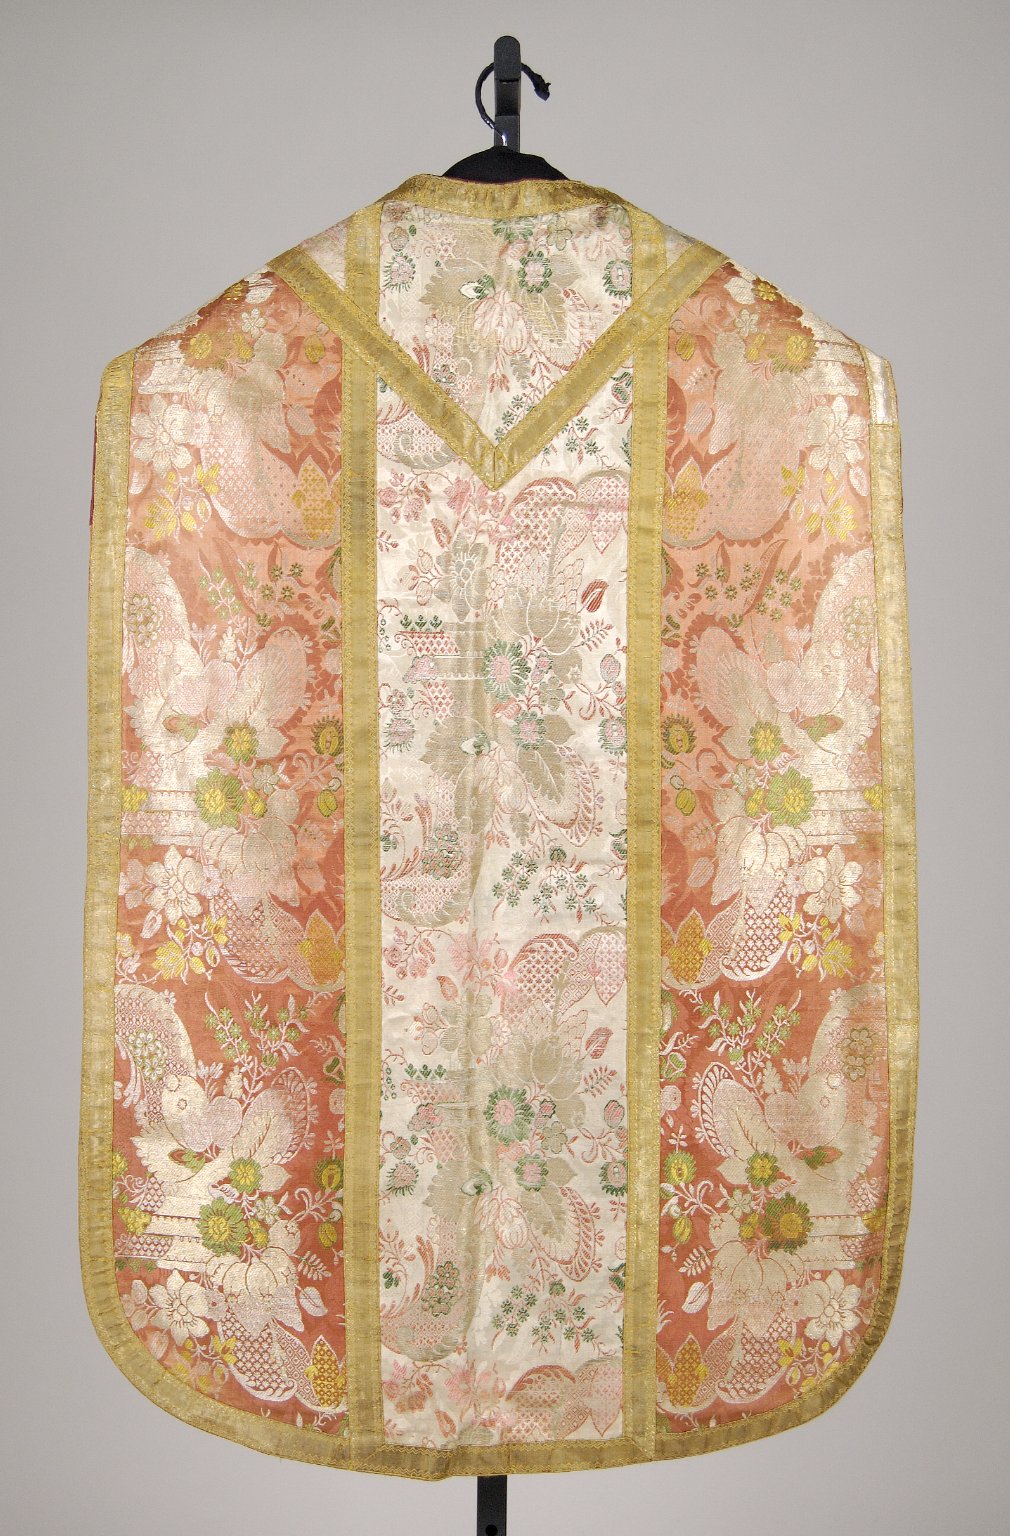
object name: chasuble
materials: silk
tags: flowers